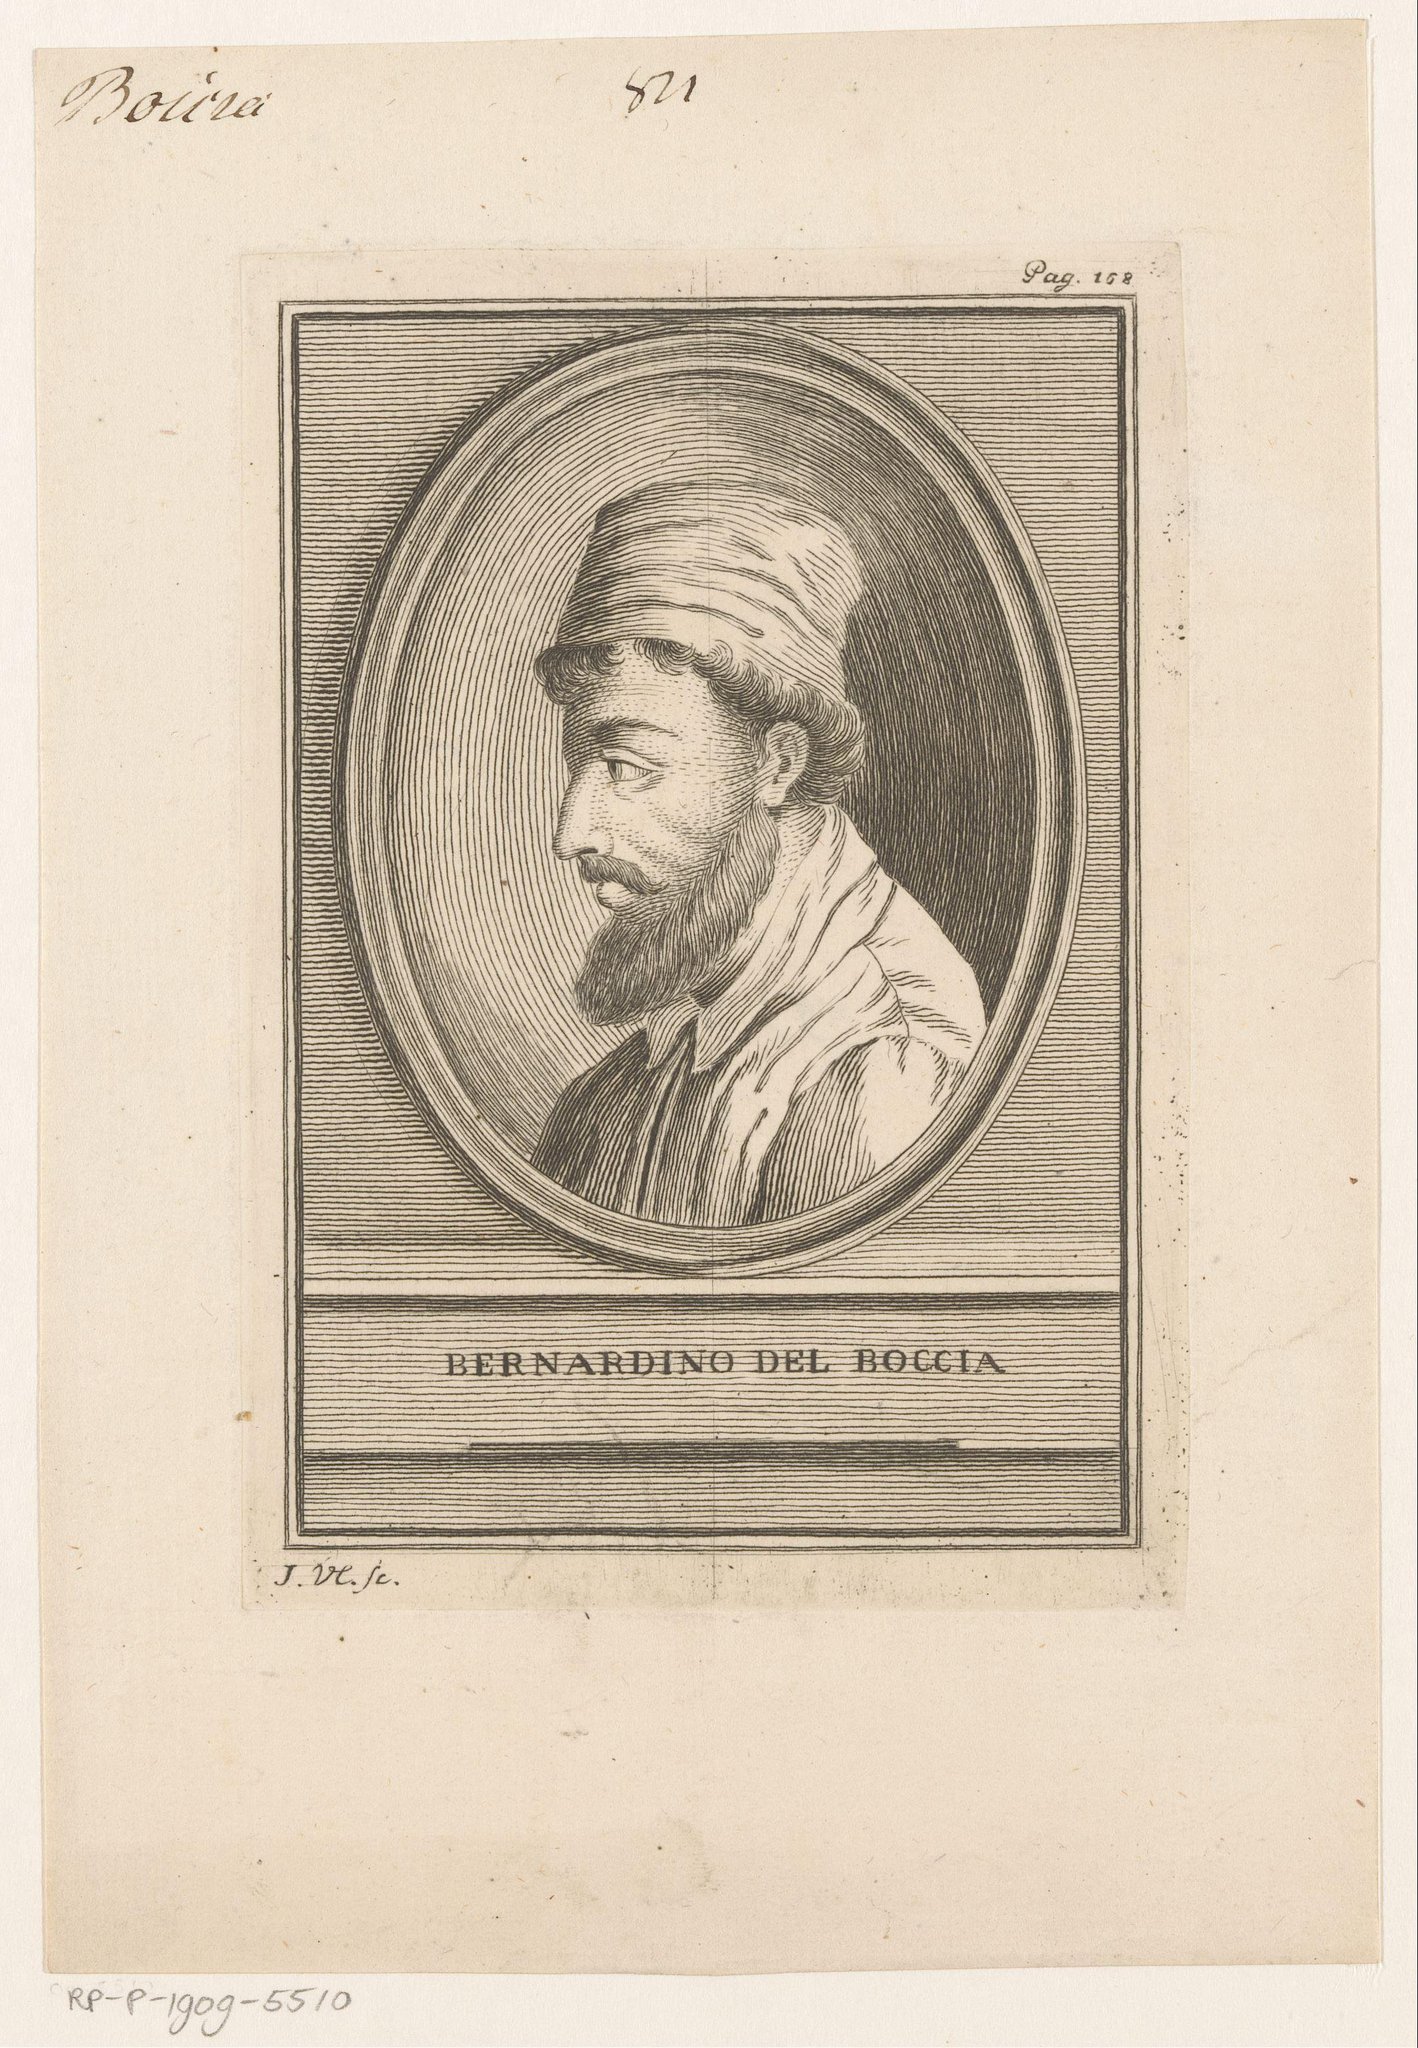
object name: print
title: Portret van liedschrijver Bernardino del Boccia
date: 1750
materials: paper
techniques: engraving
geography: lucca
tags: historical persons, portrait of a writer, writer, poet, author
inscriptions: inscription: ‘Boccia / 821’, collector's mark: Lugt 2228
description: Prent gebruikt voor Grazzini, Anton Francesco. Tutti i trionfi, carri, mascherate o canti carnascialeschi andati per Firenze dal tempo del Magnifico Lorenzo de' Medici fino all' anno 1559 : in questa seconda edizione corretti, con diversi MSS. collazionati, delle loro varie lezioni arricchiti, notabilmente accresciuti, e co' ritratti di ciascun poeta adornate. Lucca: Cosmopoli, 1750.